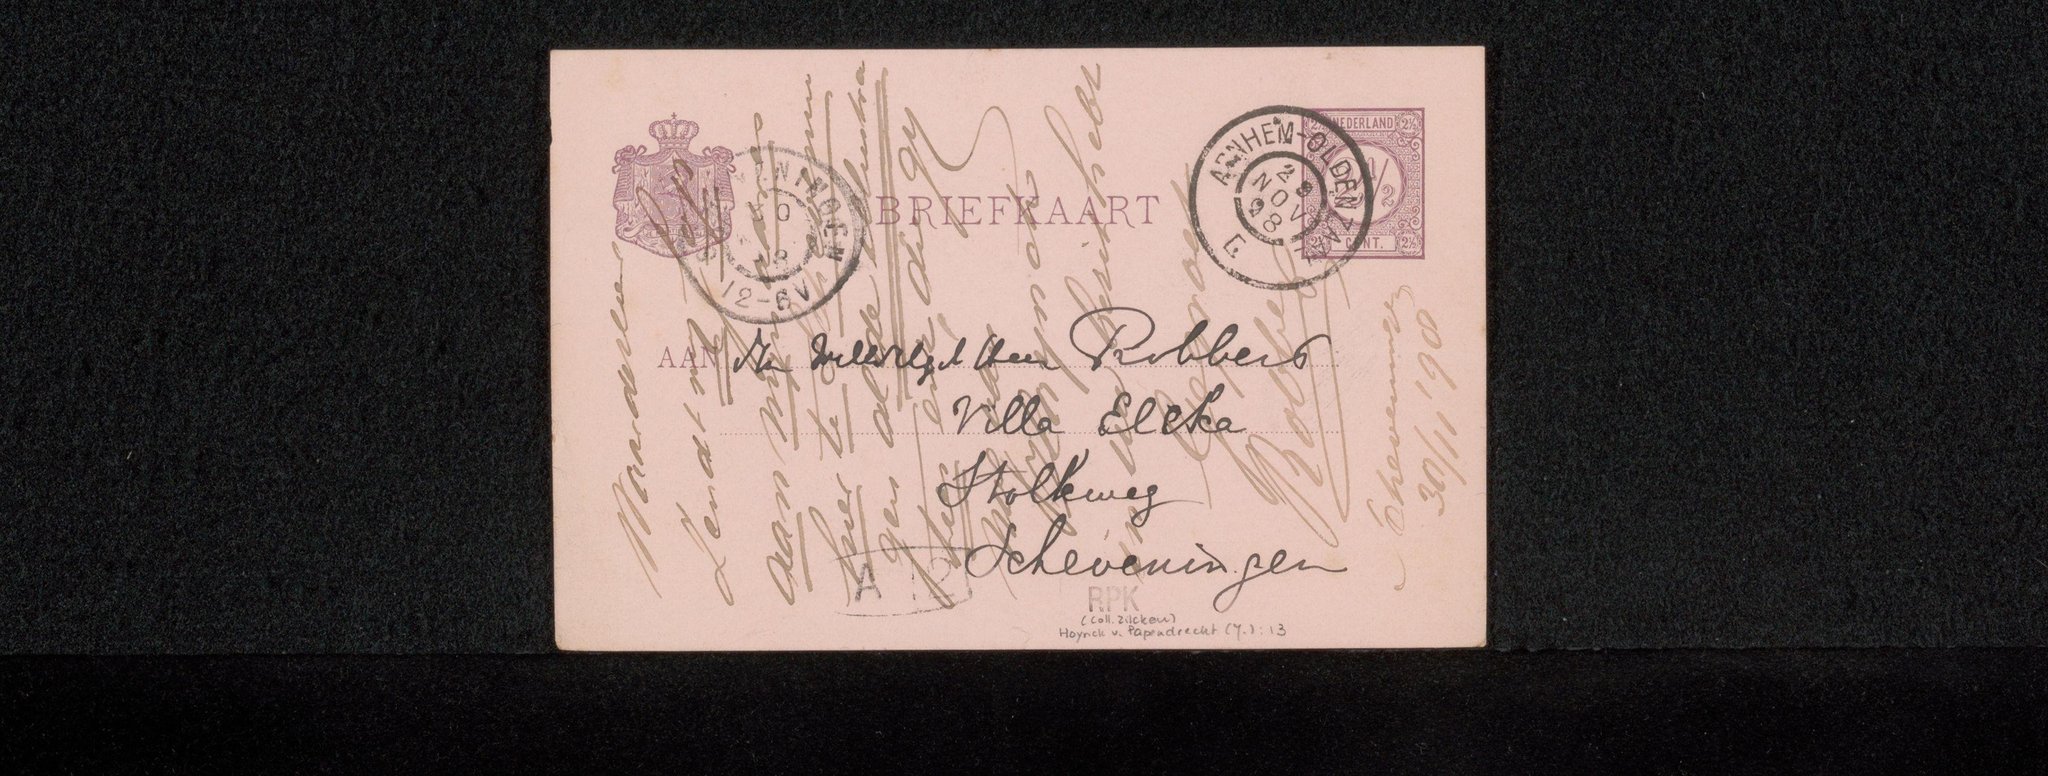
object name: postcard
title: Briefkaart aan Herman Robbers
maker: jan hoynck van papendrecht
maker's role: draughtsman, painter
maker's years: 1858-1933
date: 1898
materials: cardboard, ink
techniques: pen, writing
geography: rheden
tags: rotterdam, herman robbers, philip zilcken, criticizing and discussing art, art criticism, drawing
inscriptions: collector's mark: ‘RPK’